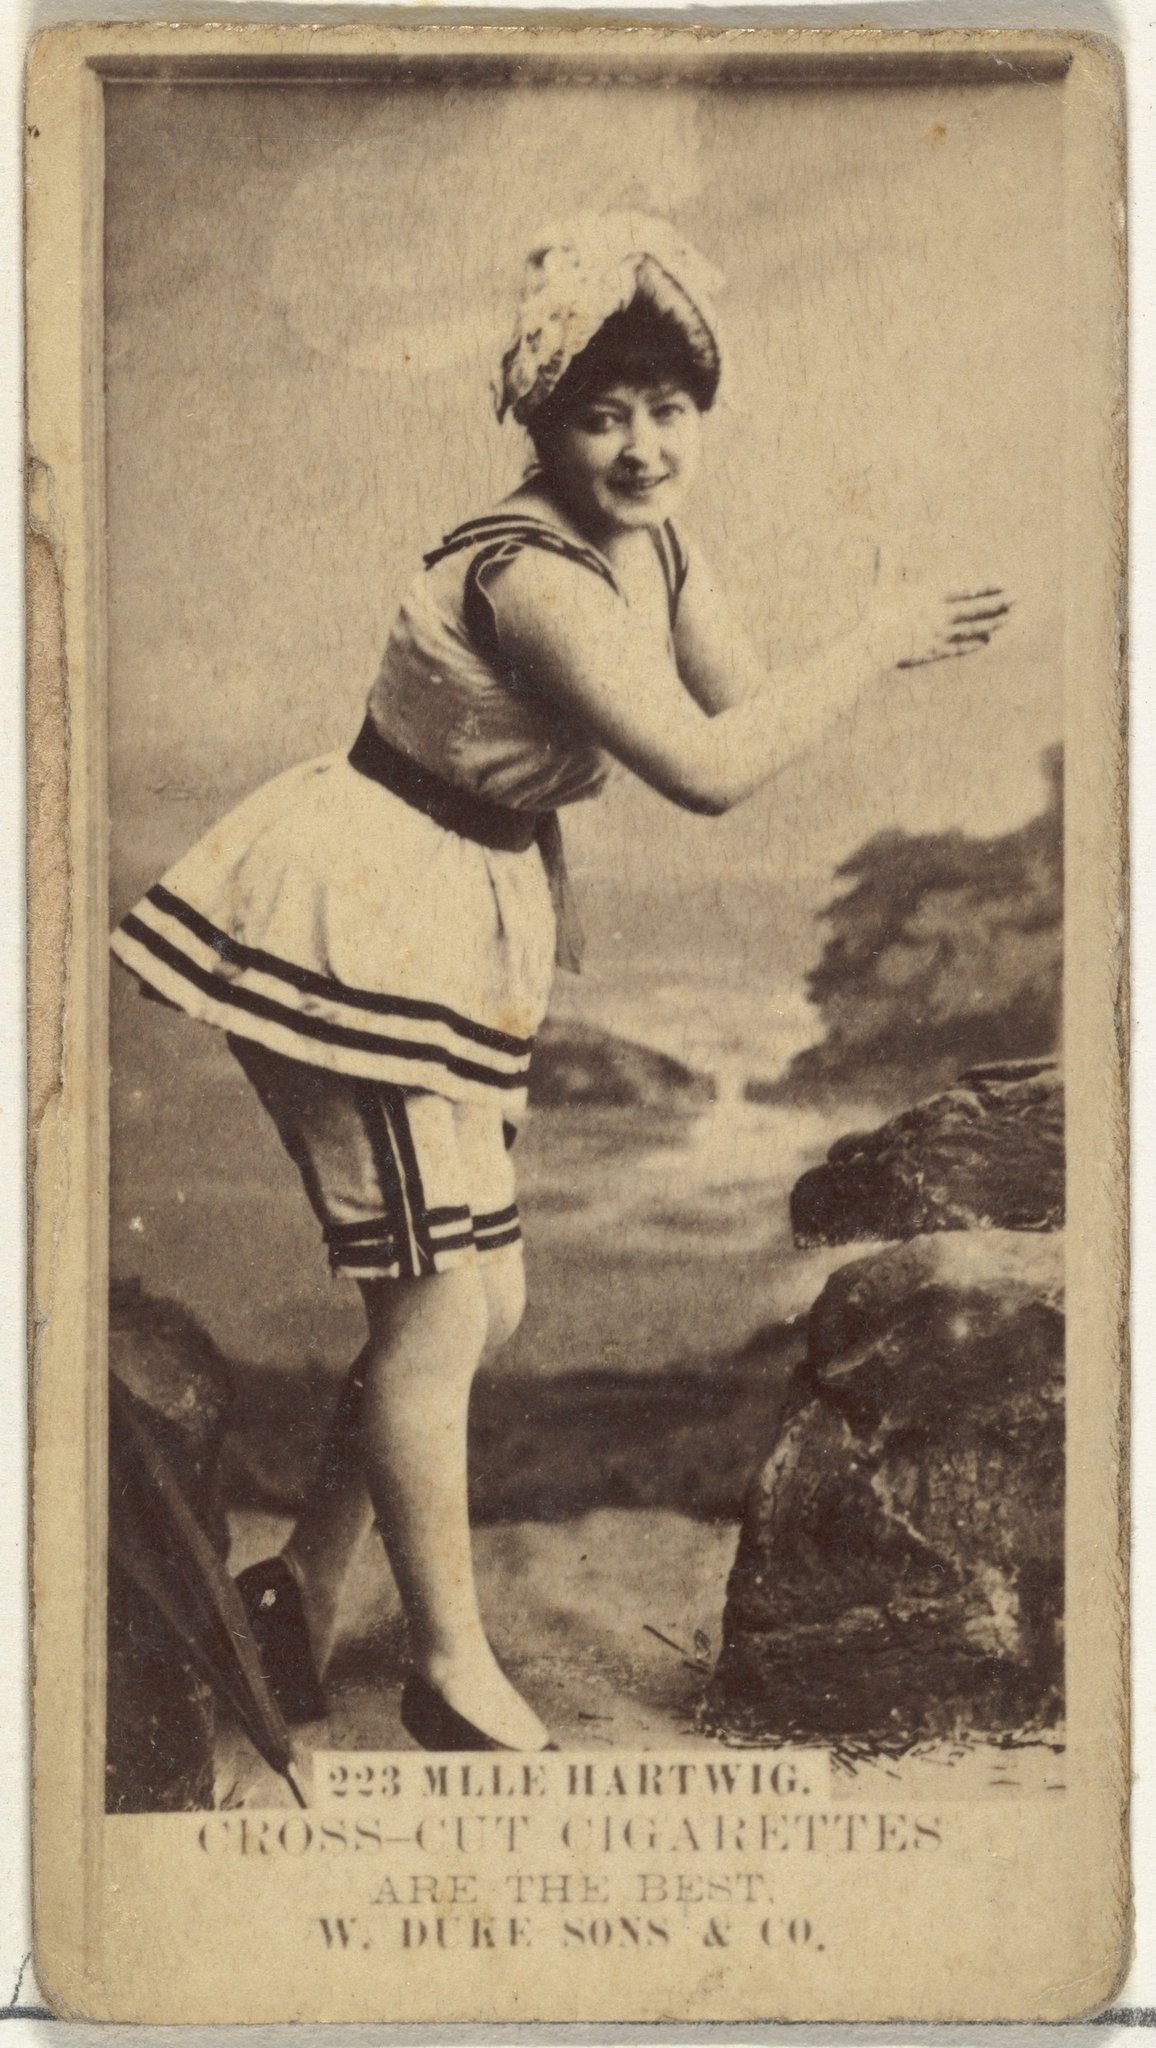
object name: photograph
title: Card Number 223, Mlle. Hartwig, from the Actors and Actresses series (N145-3) issued by Duke Sons & Co. to promote Cross Cut Cigarettes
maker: w. duke, sons & co.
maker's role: publisher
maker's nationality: american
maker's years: 1870-1920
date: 1880-1889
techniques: albumen silver print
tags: portraits,women,actresses